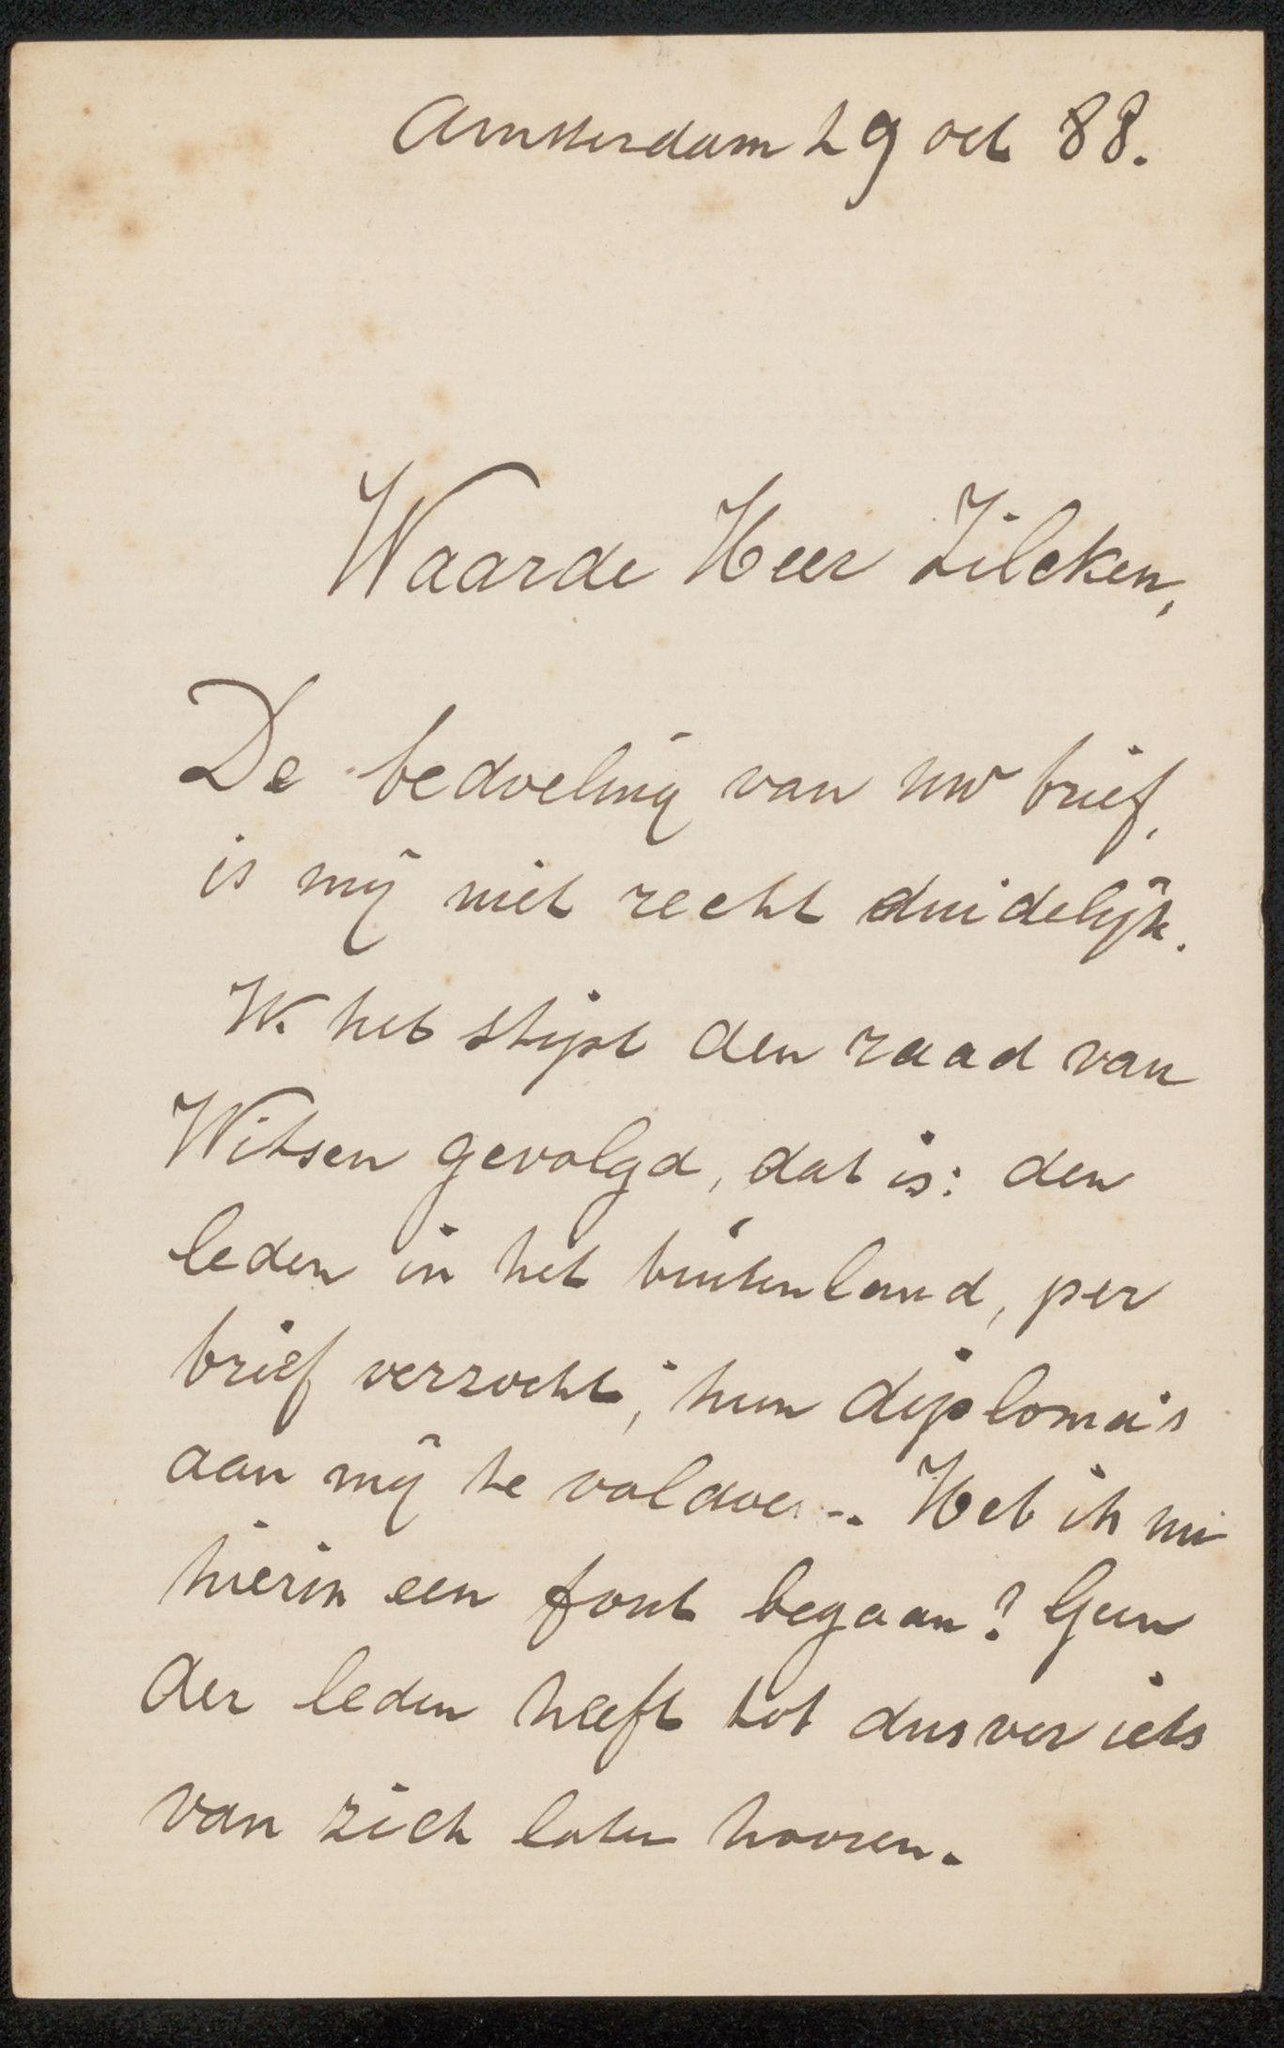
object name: letter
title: Brief aan Philip Zilcken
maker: eduard karsen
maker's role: draughtsman, painter, print maker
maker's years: 1860-1941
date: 1888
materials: ink, paper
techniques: pen, writing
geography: amsterdam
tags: amsterdam, painter, print maker, draughtsman, willem witsen, the hague, philip zilcken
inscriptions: collector's mark: ‘RPK’